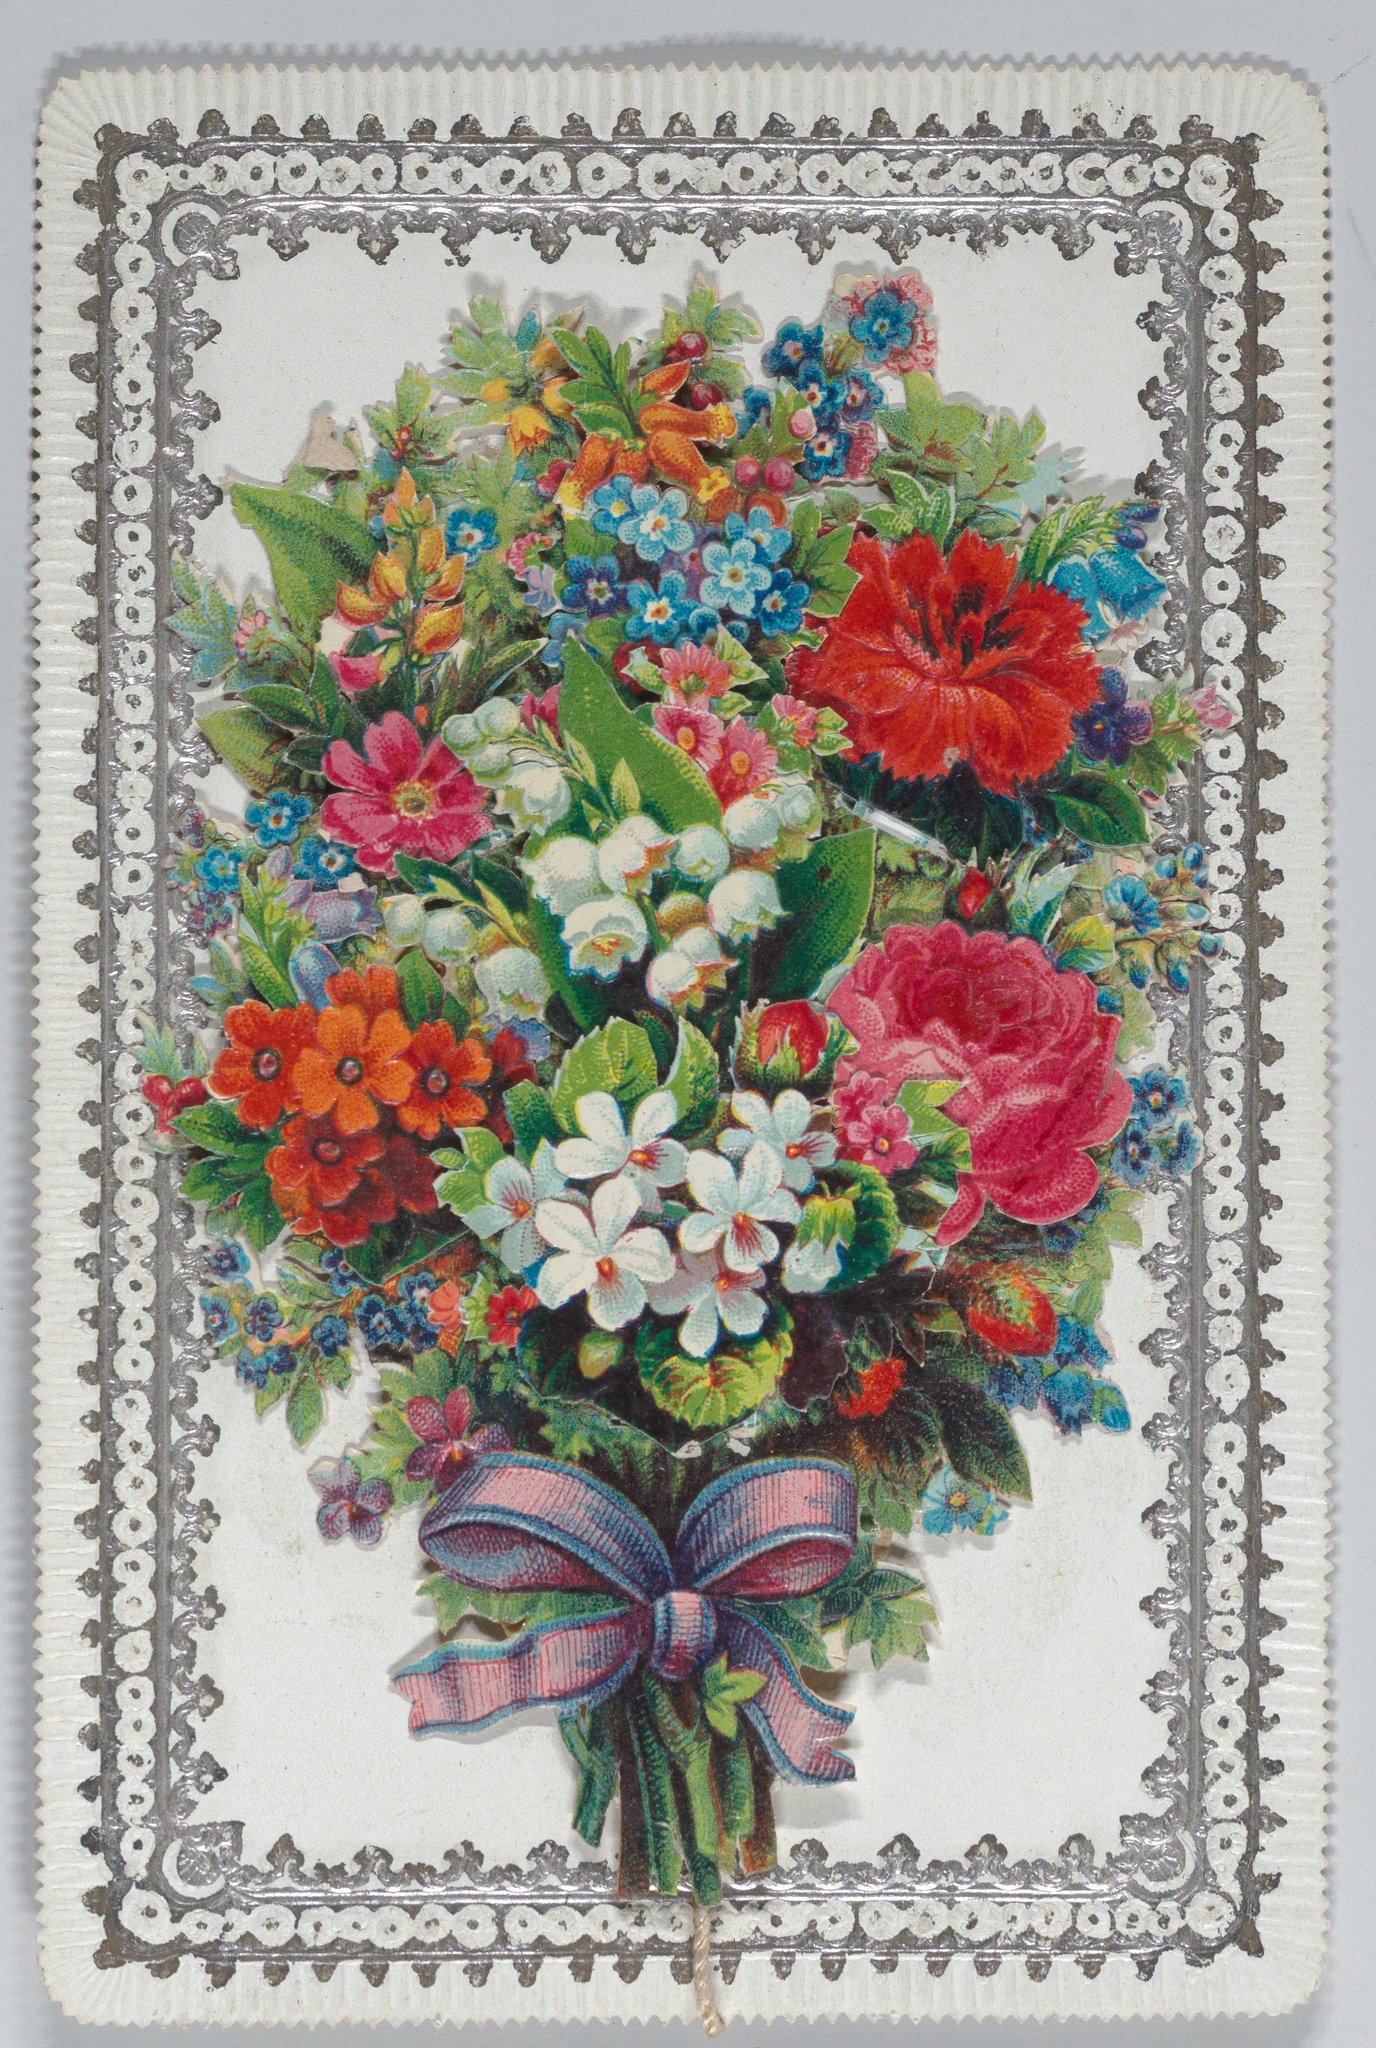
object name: valentine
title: Valentine - Mechanical bouquet, holidays, wedding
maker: anonymous, british, 19th century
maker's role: artist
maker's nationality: british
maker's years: 1800-1900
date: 1875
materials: silver, thread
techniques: chromolithography, cutting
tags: flowers